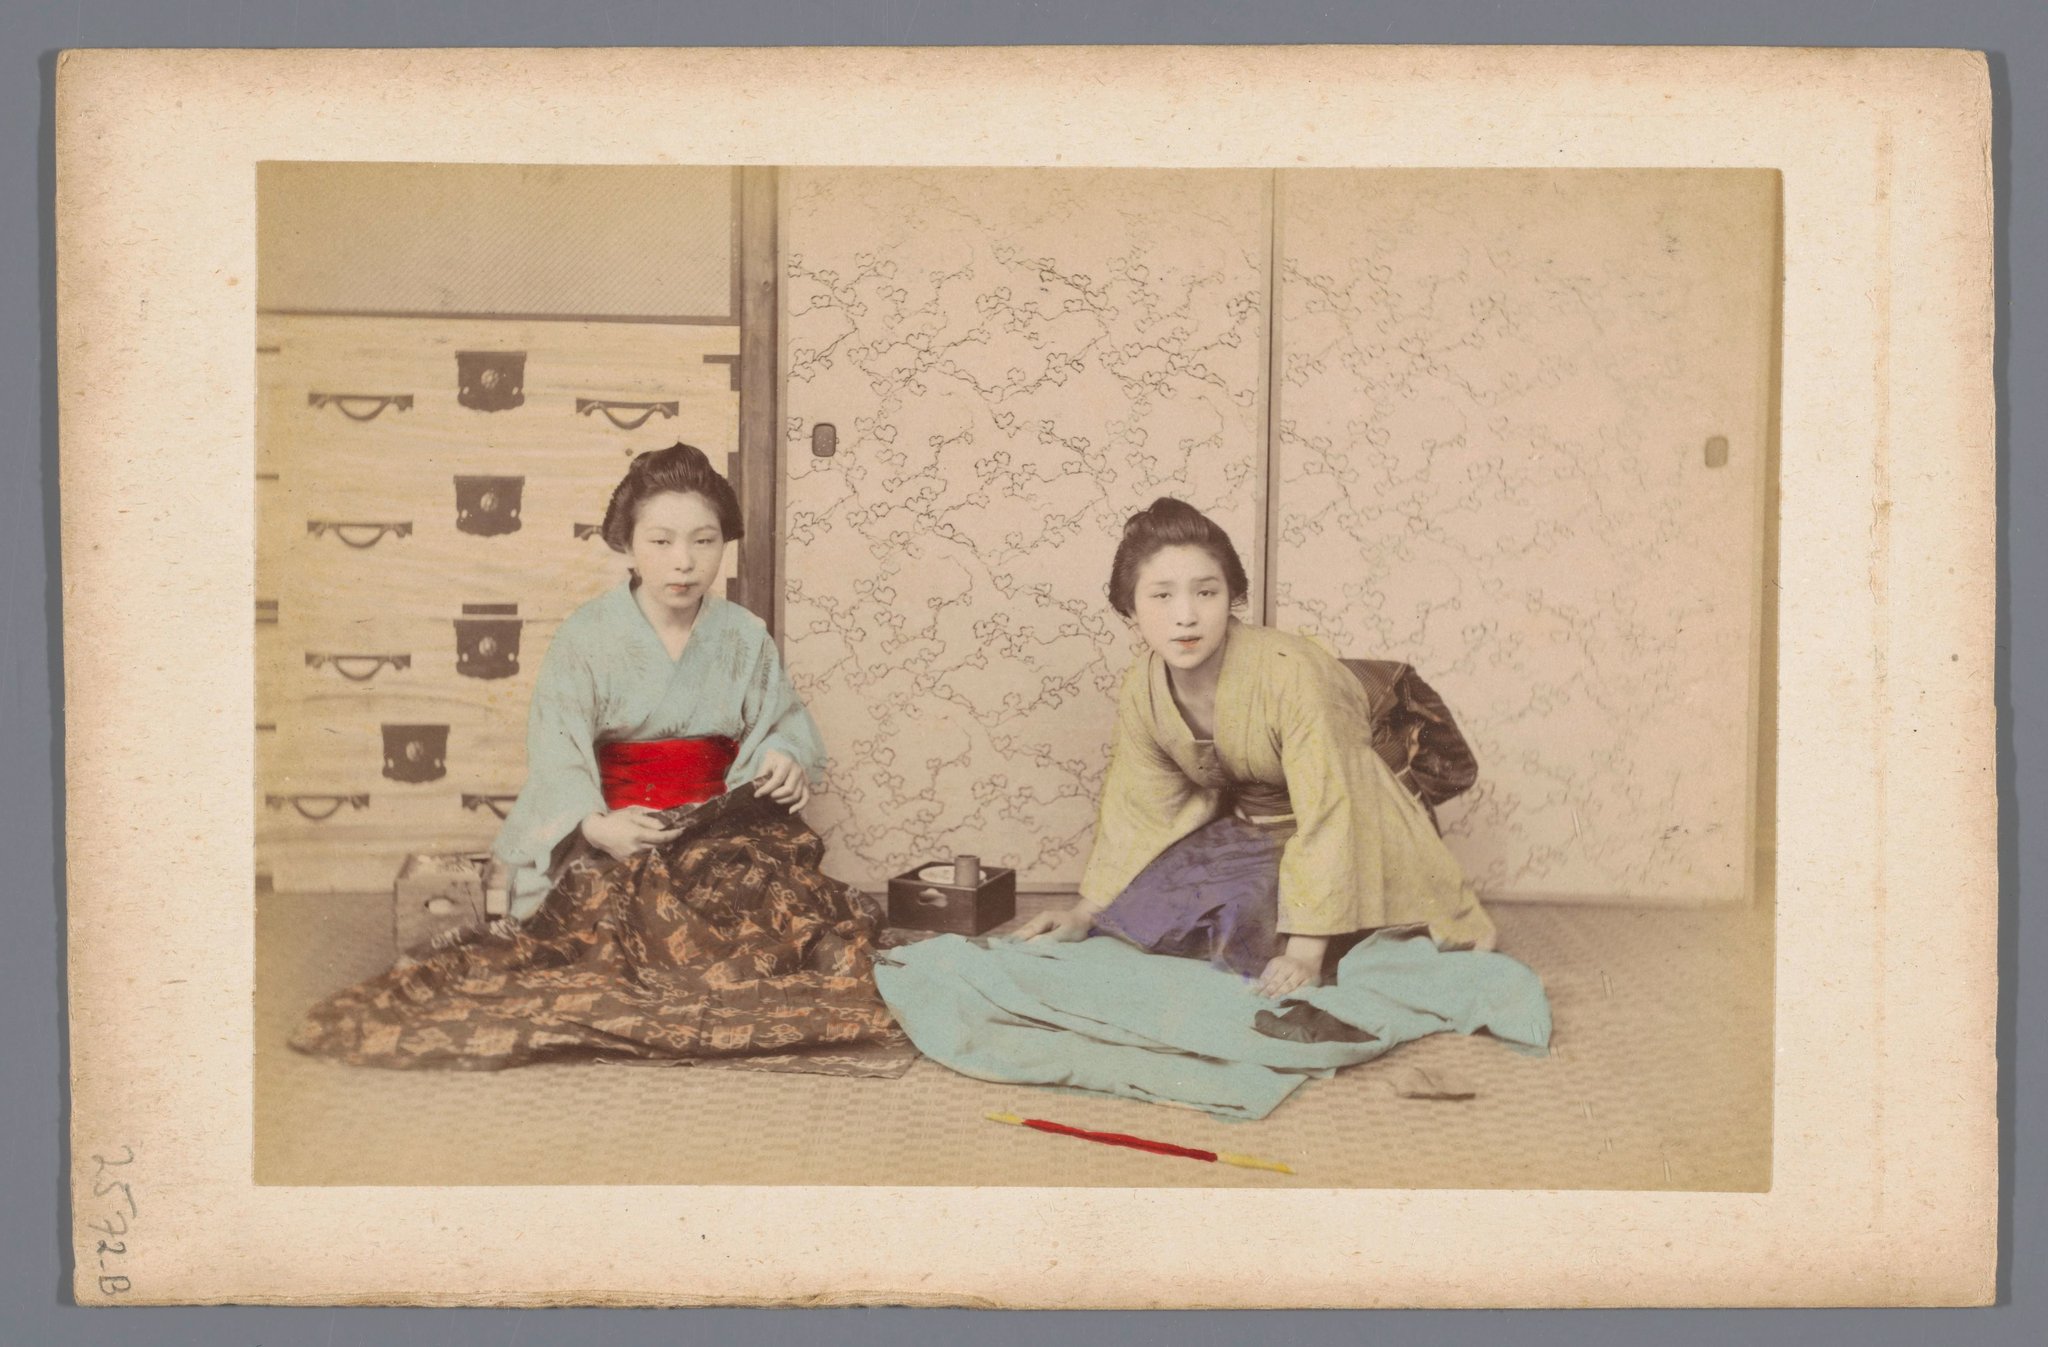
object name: photograph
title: Dubbelportret van twee onbekende Japanse vrouwen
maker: Anonymous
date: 1860-1900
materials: cardboard, paper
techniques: albumen print, hand coloring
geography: japan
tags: anonymous historical persons portrayed in a double portrait - bb - woman, japan